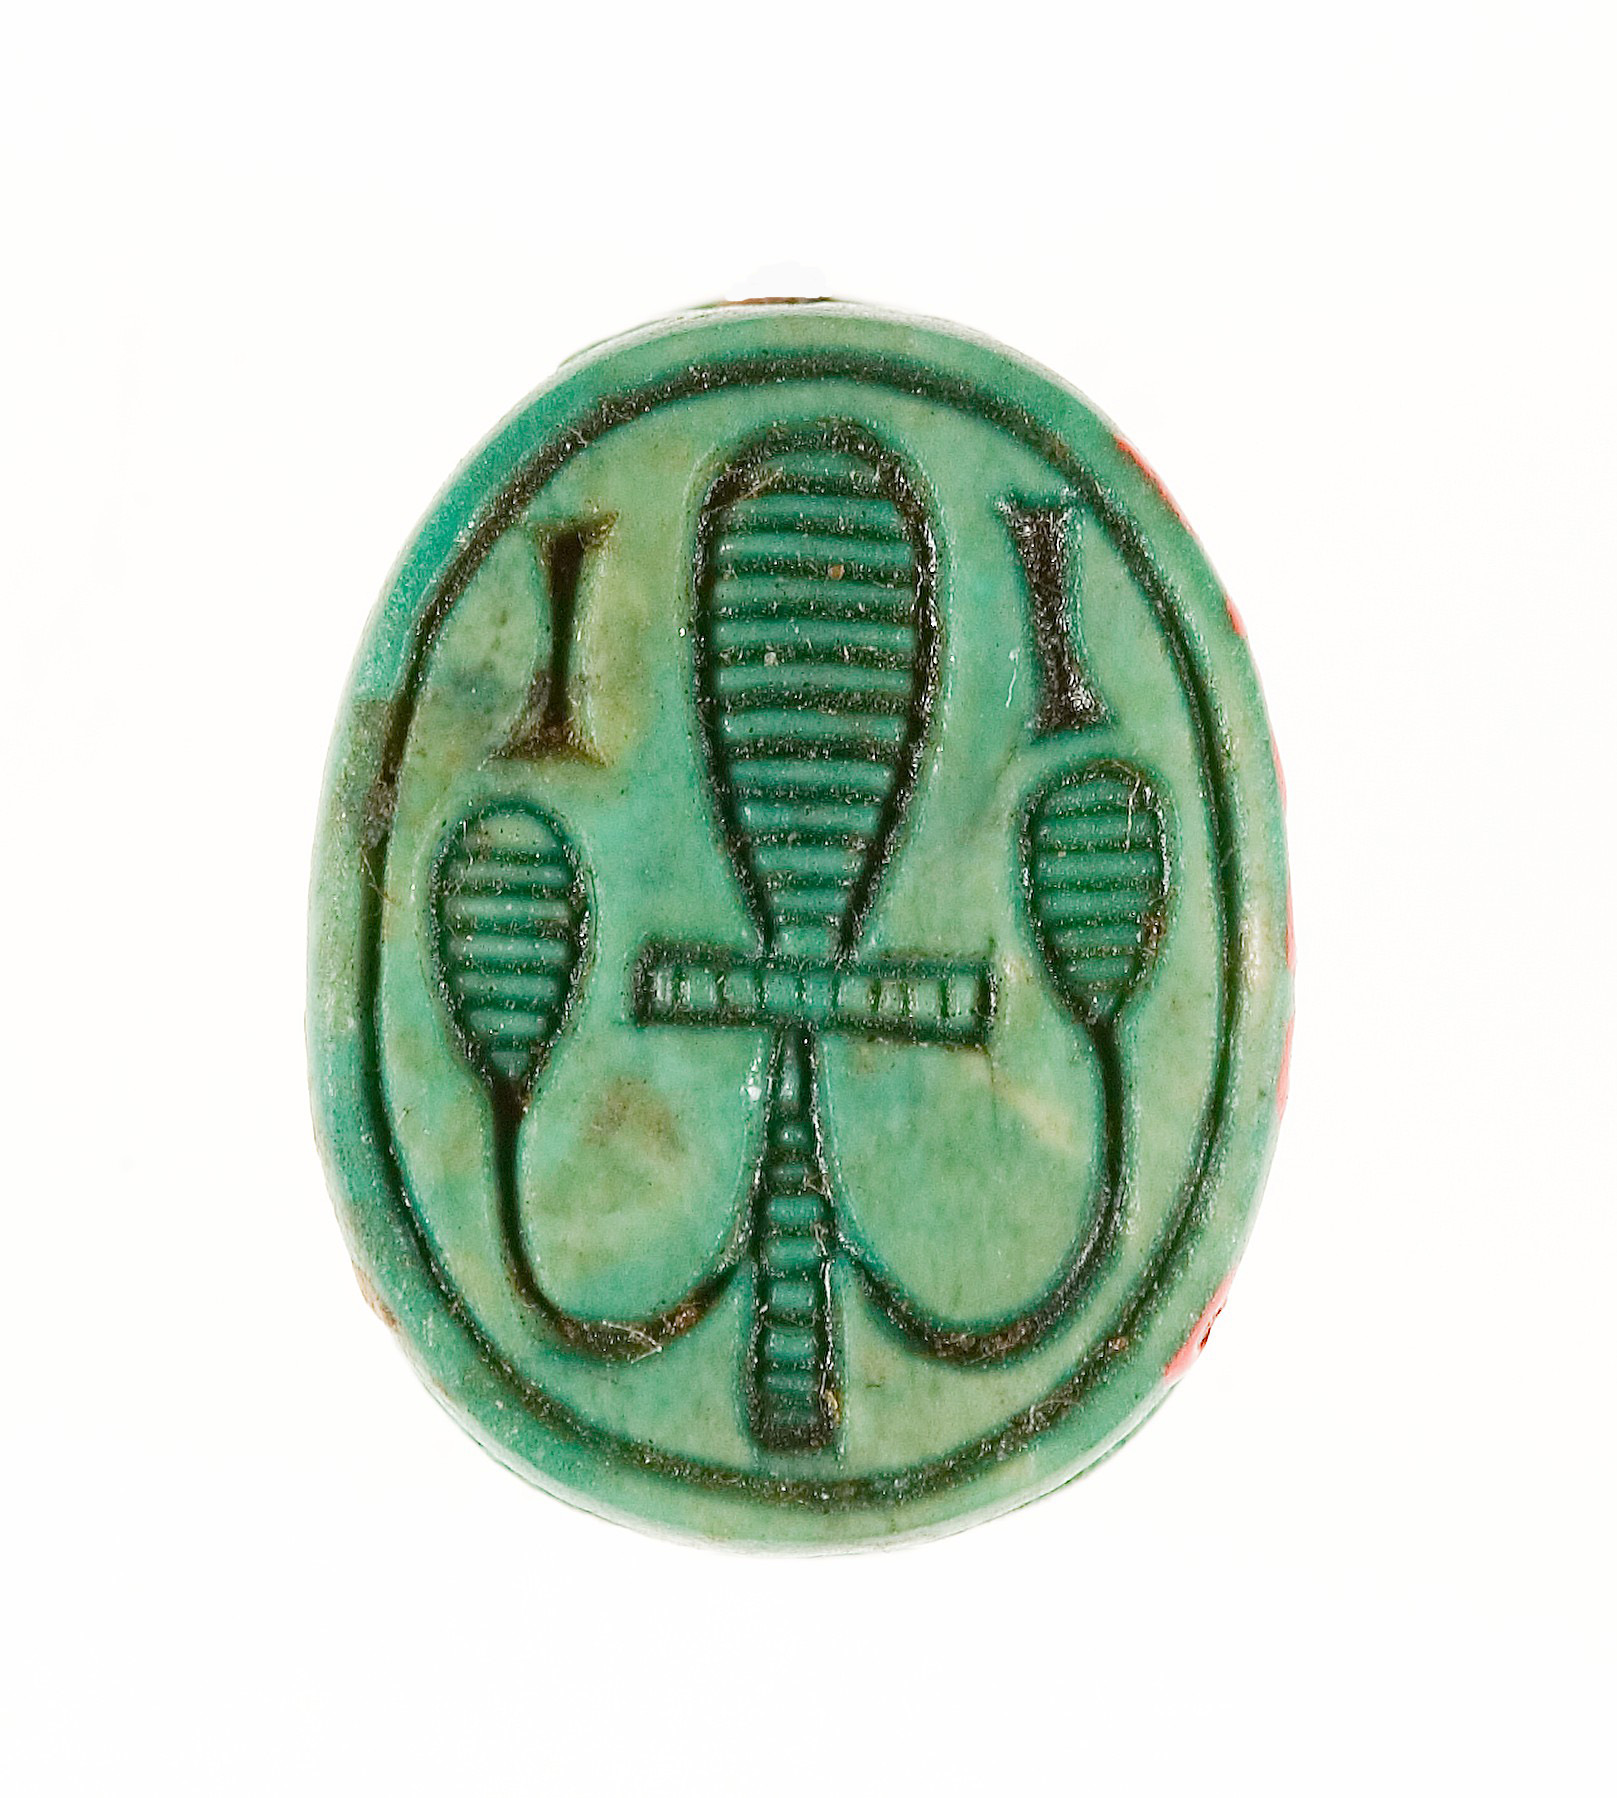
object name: scarab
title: Scarab Inscribed with a Geometric Pattern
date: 1479-1458 BCE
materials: stone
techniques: glazing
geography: egypt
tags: scarabs